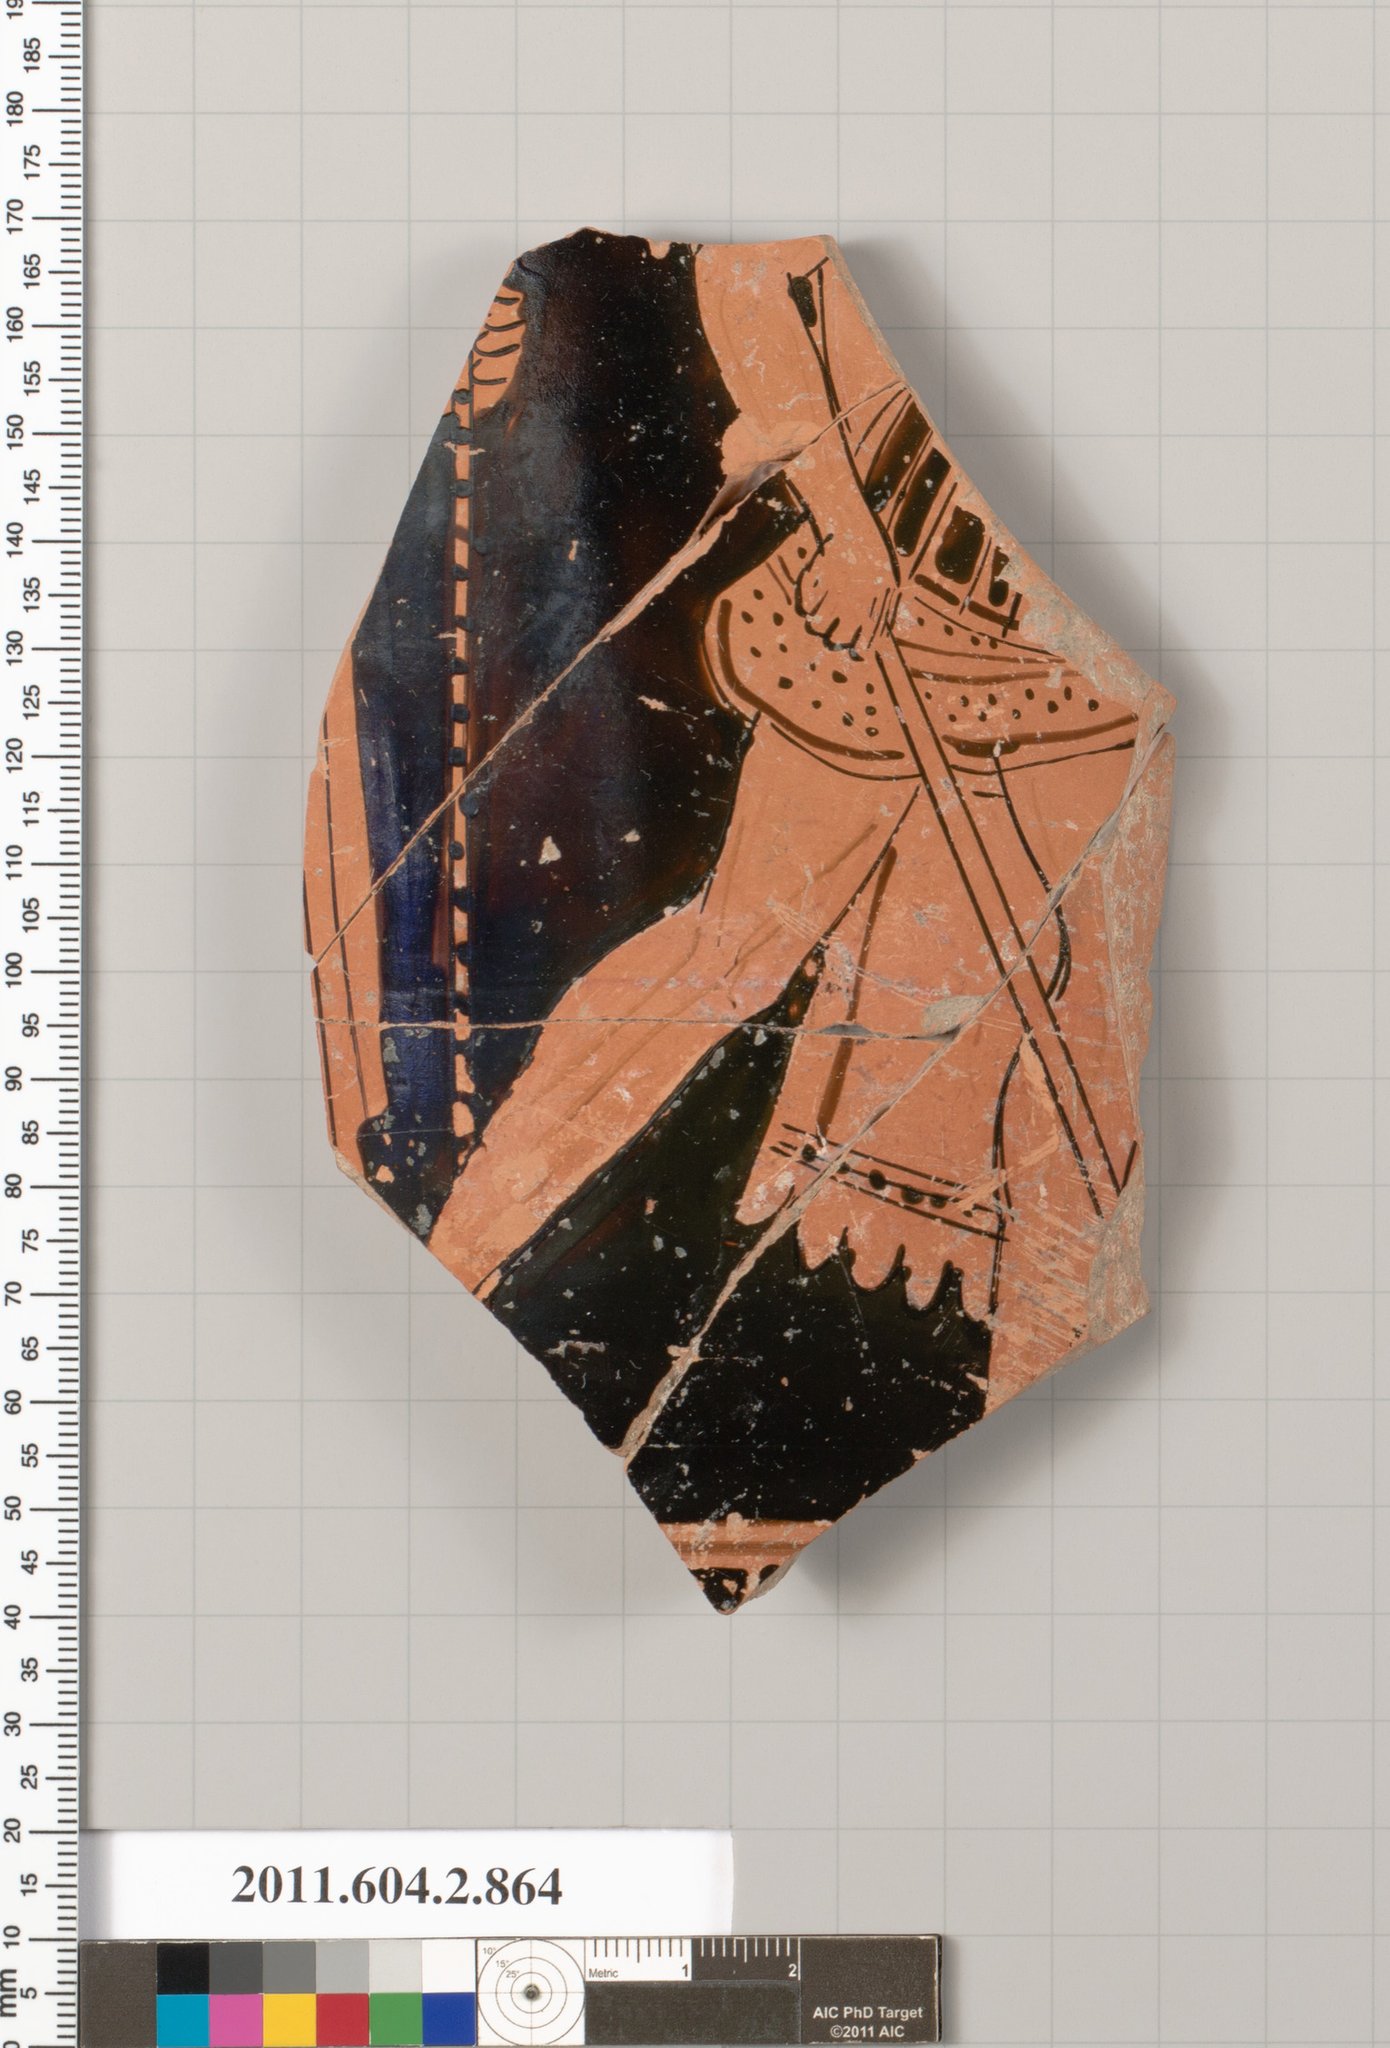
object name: bell krater fragment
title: Terracotta fragment of a bell-krater (bowl for mixing wine and water)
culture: greek, attic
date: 450-440 BCE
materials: terracotta